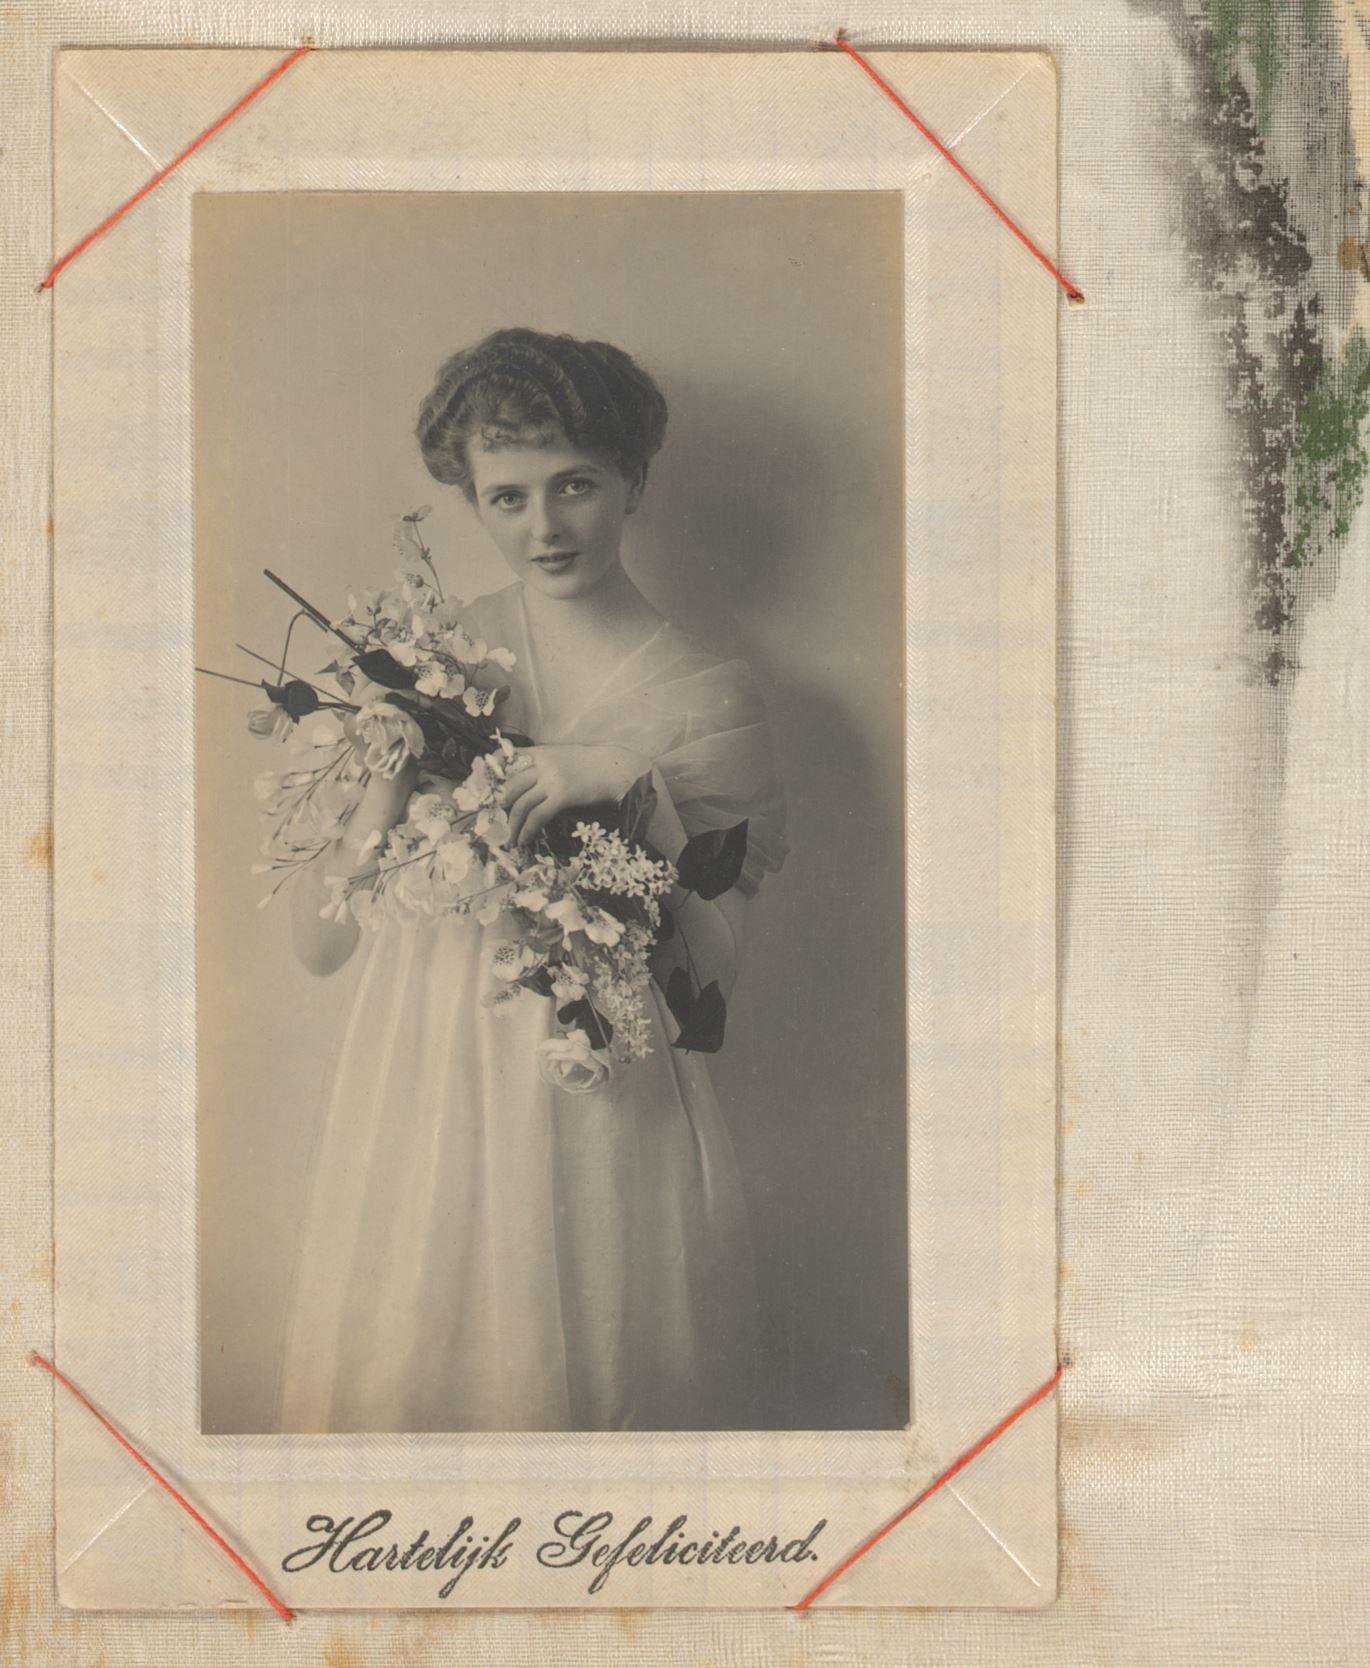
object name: album leaf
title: Portret van een vrouw met bloemen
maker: Anonymous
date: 1880-1920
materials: paint, photographic support, silk, textile, watercolor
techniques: brush, gelatin silver print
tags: flowers, adult woman, historical persons